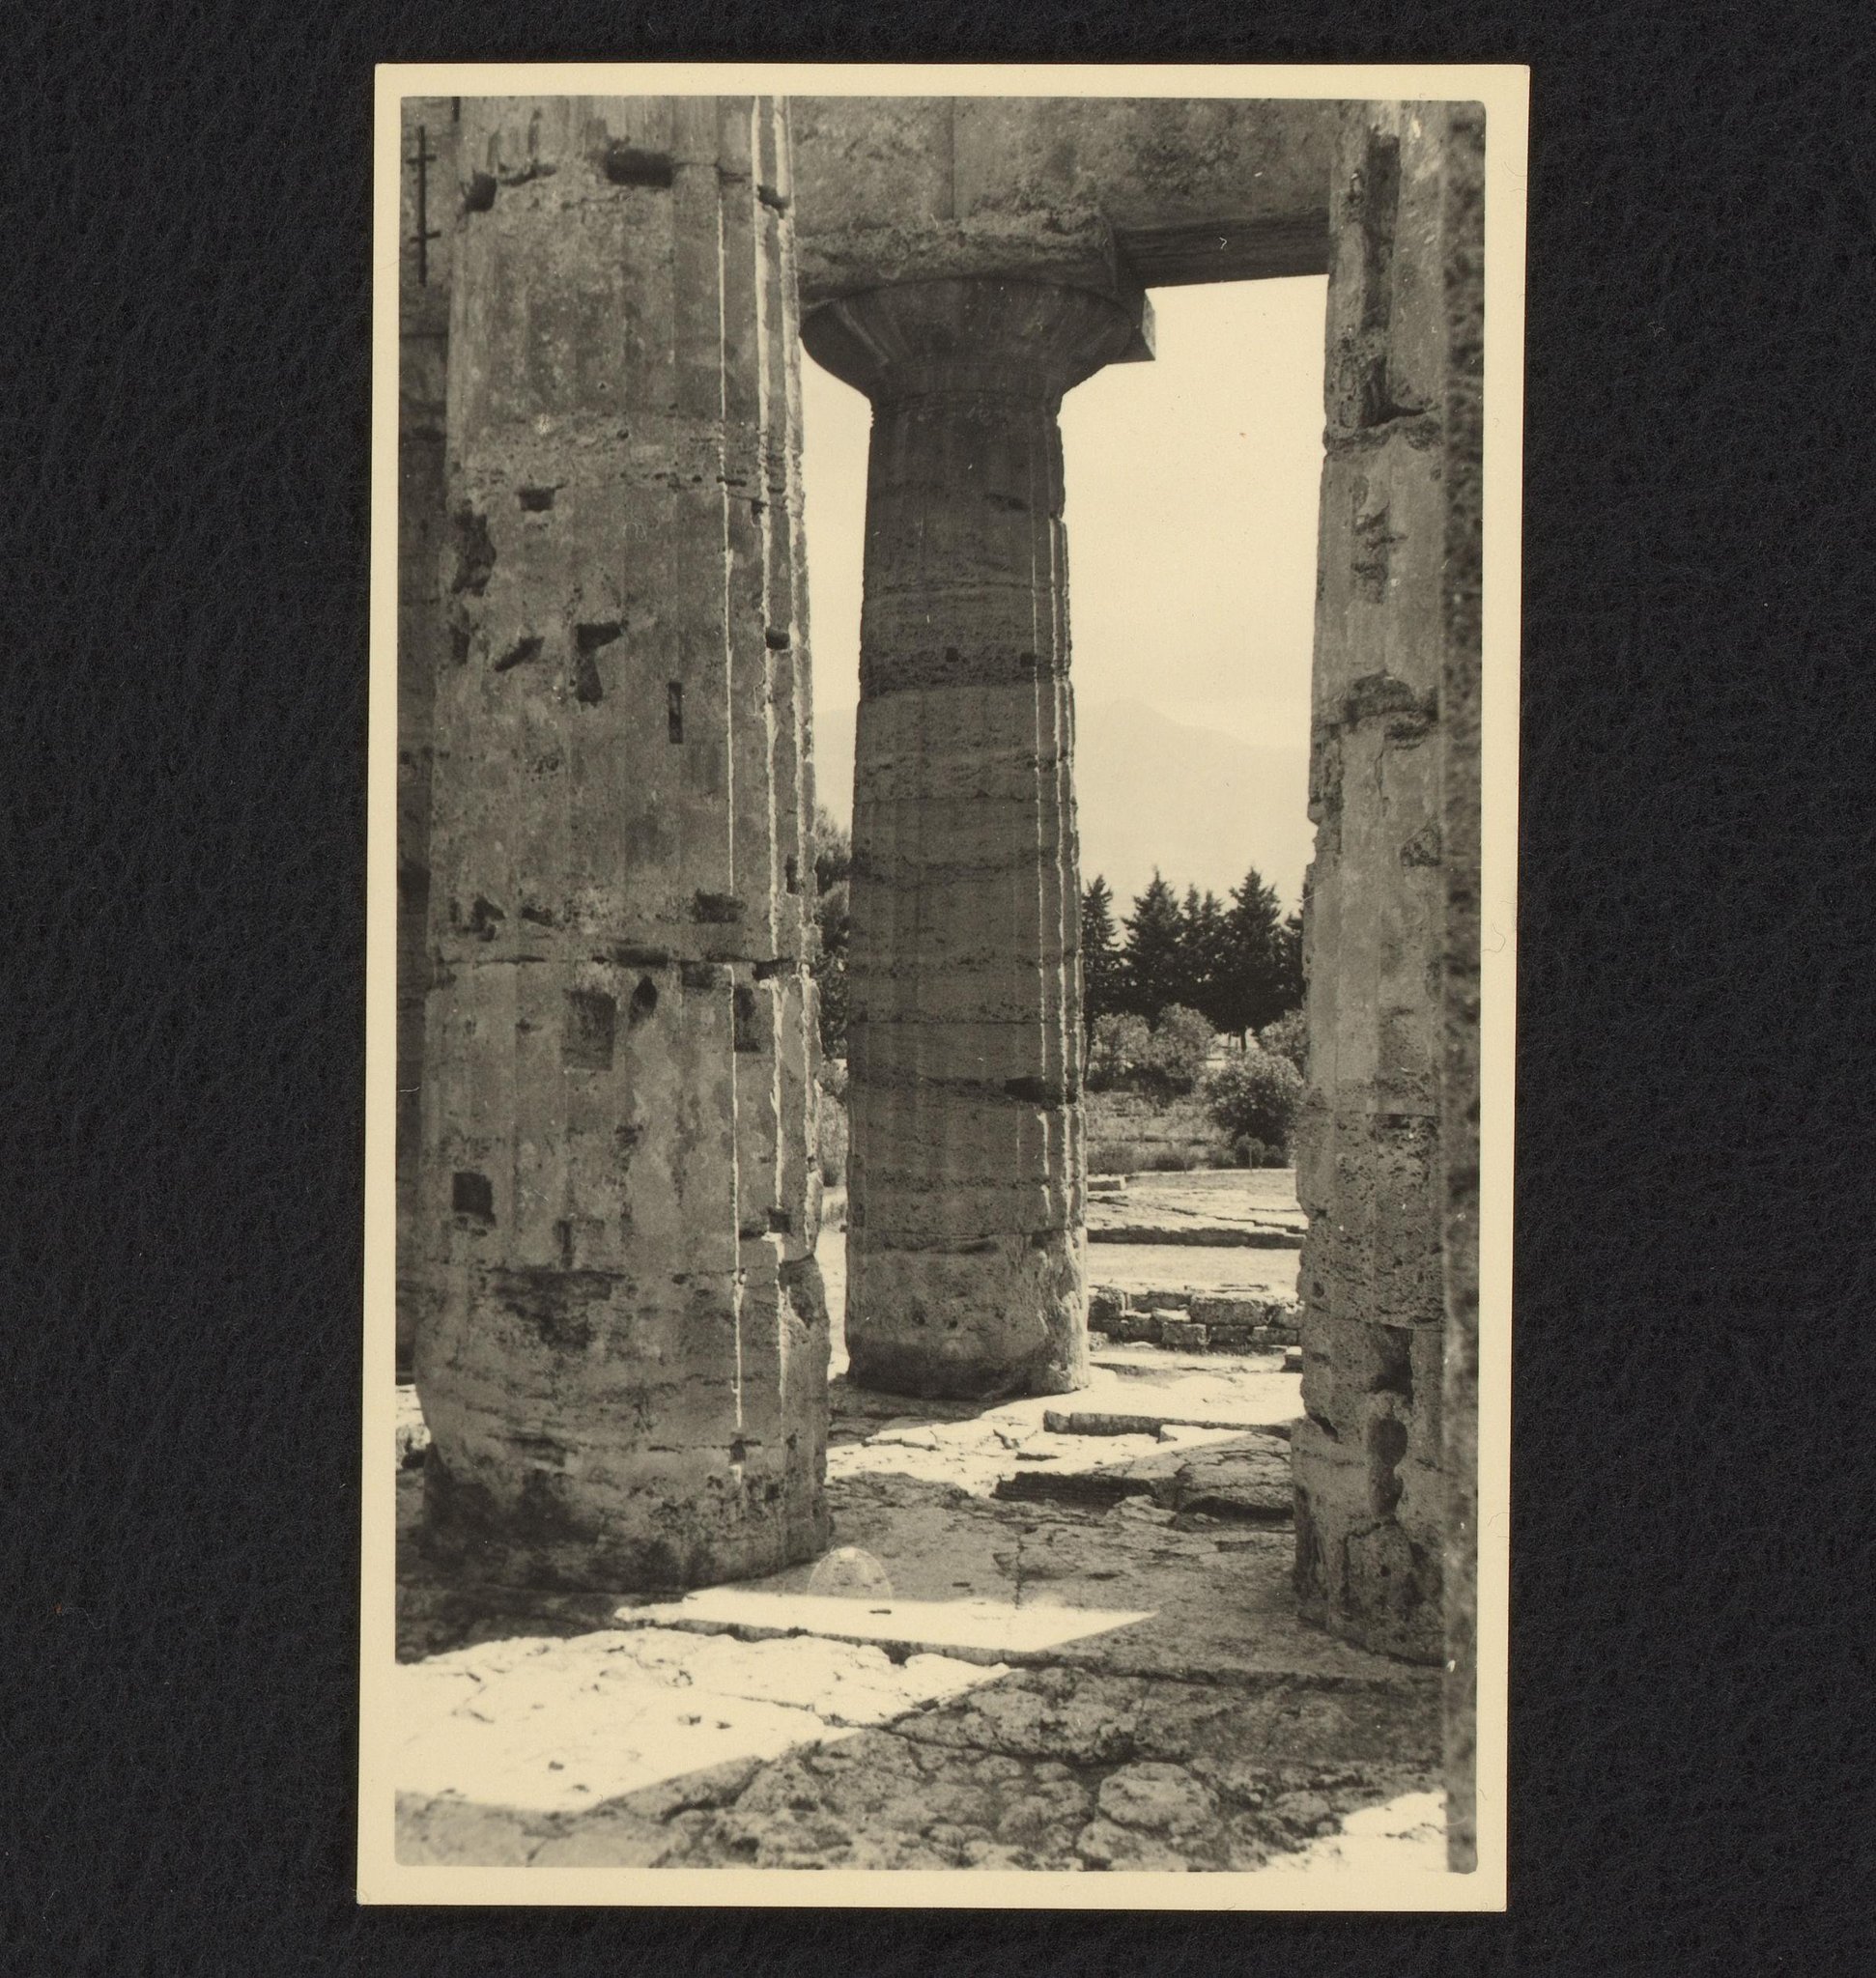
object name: photograph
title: Sorrento - Panorama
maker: vincenzo carcavallo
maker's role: publisher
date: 1954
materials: paper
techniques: gelatin silver print, writing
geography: sorrento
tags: gulf, bay, village, sorrento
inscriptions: poststempel, verso, gestempeld